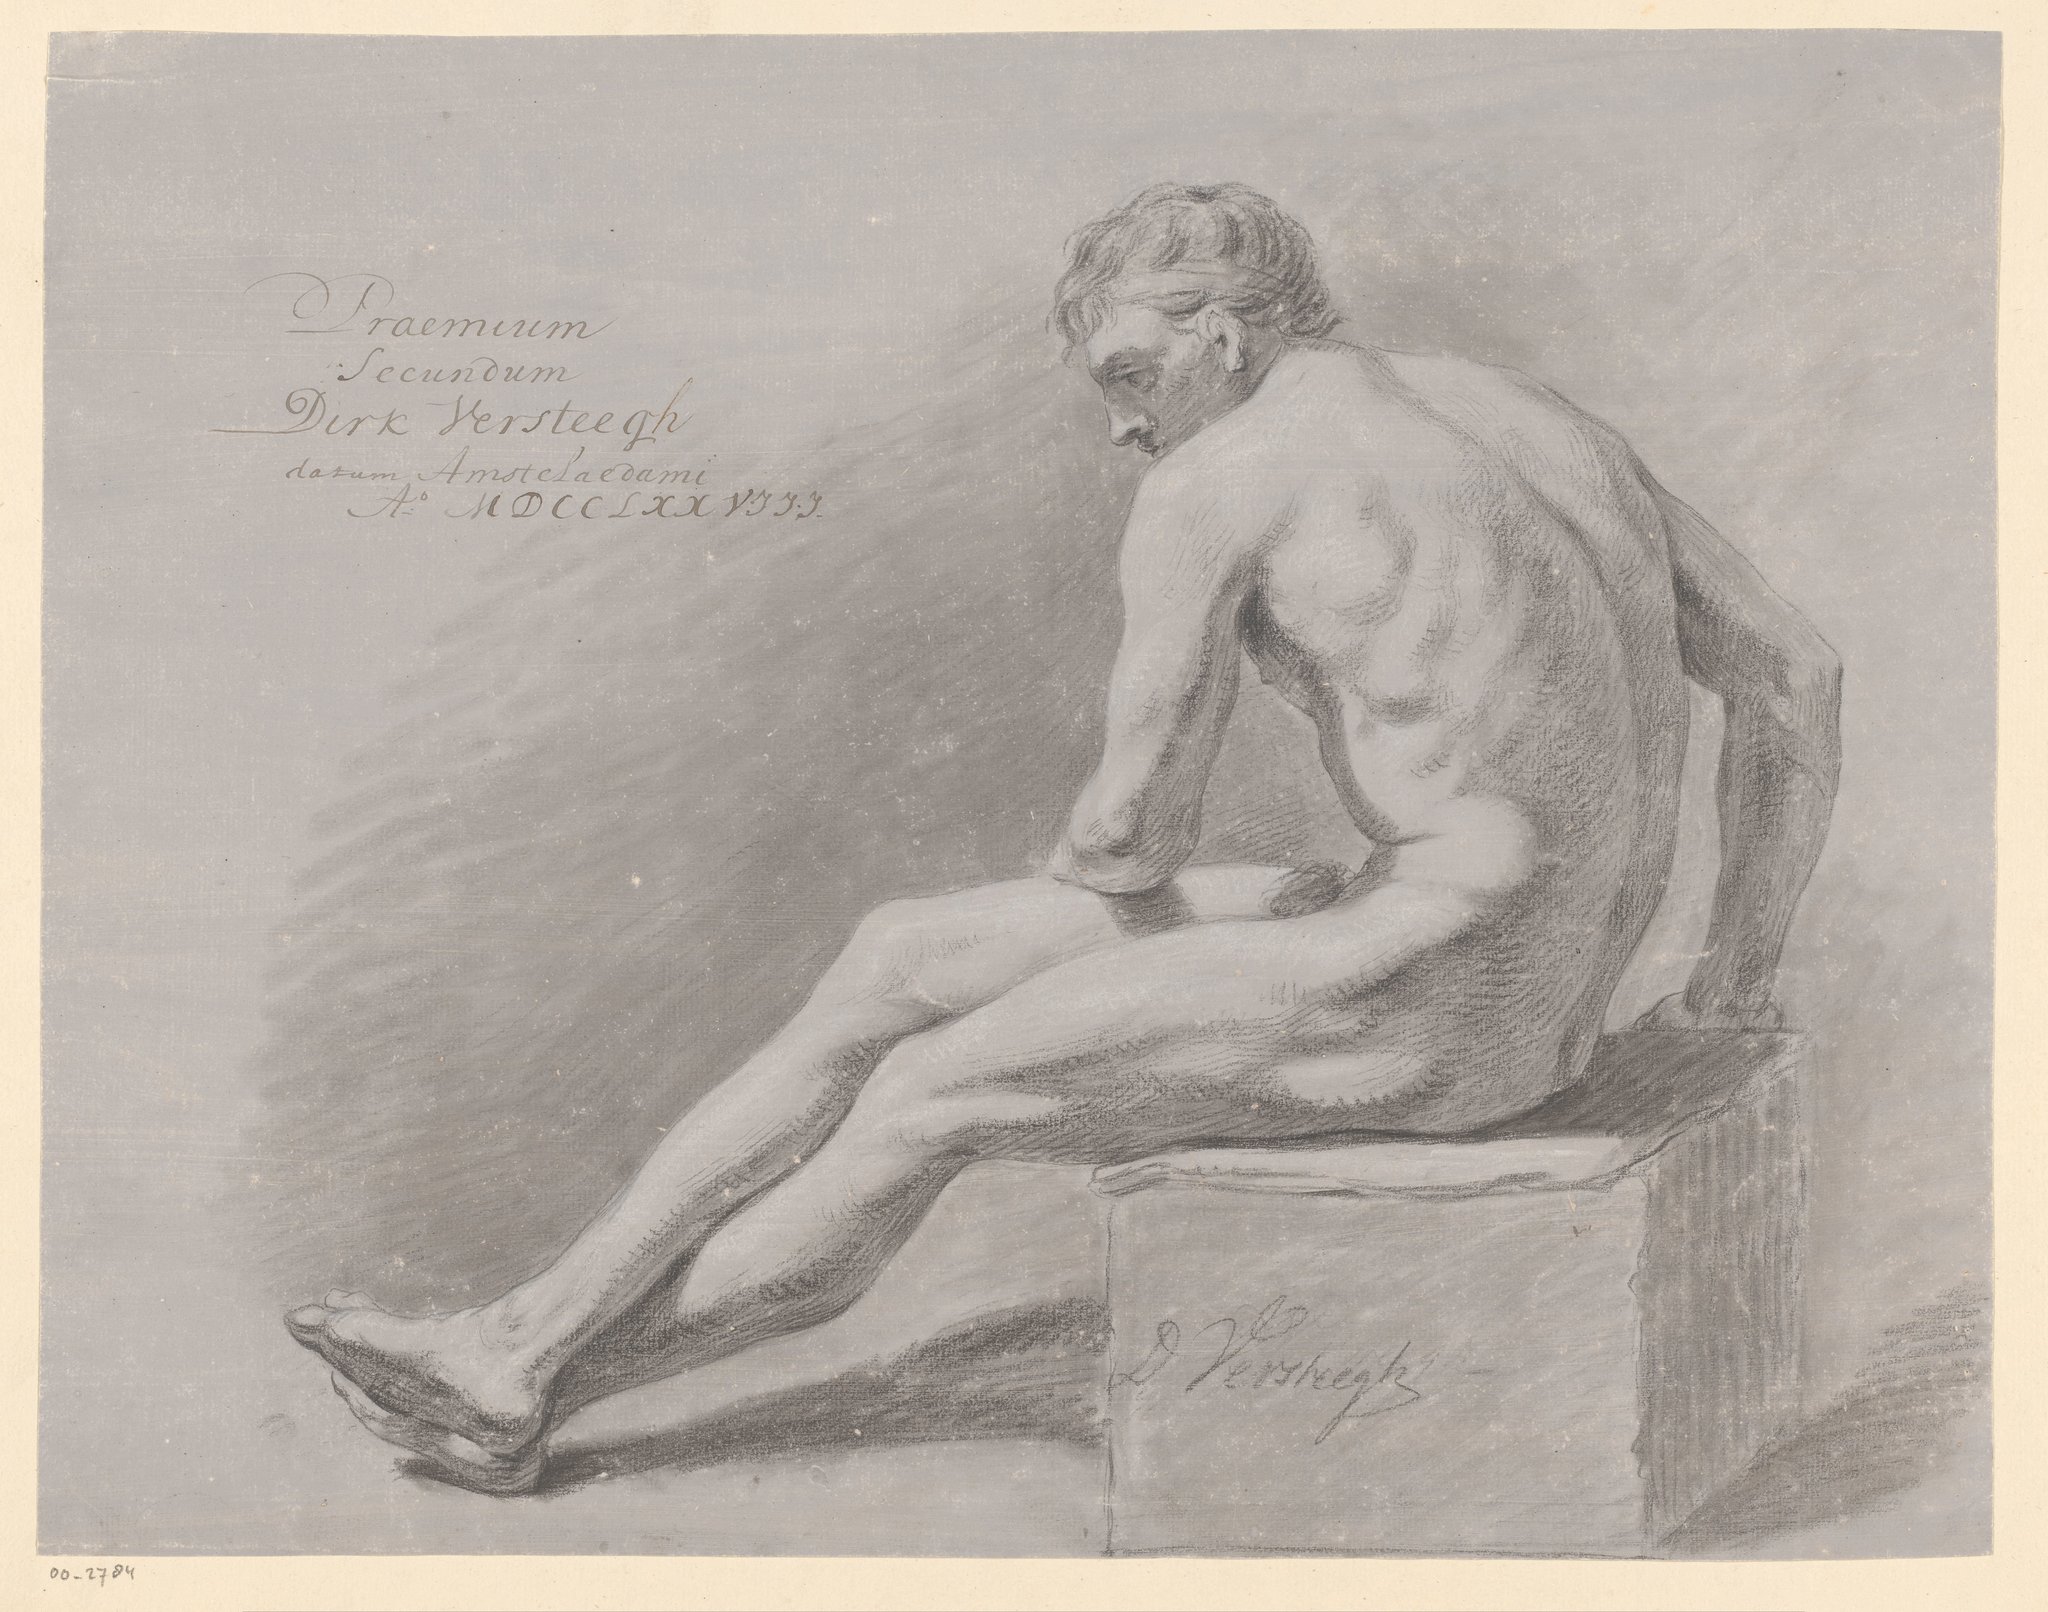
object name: drawing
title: Zittend mannelijk naakt, van opzij gezien (2e prijs 1778)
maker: dirk versteegh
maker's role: draughtsman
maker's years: 1751-1822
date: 1778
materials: chalk, paper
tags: sitting figure (+ nude human being)